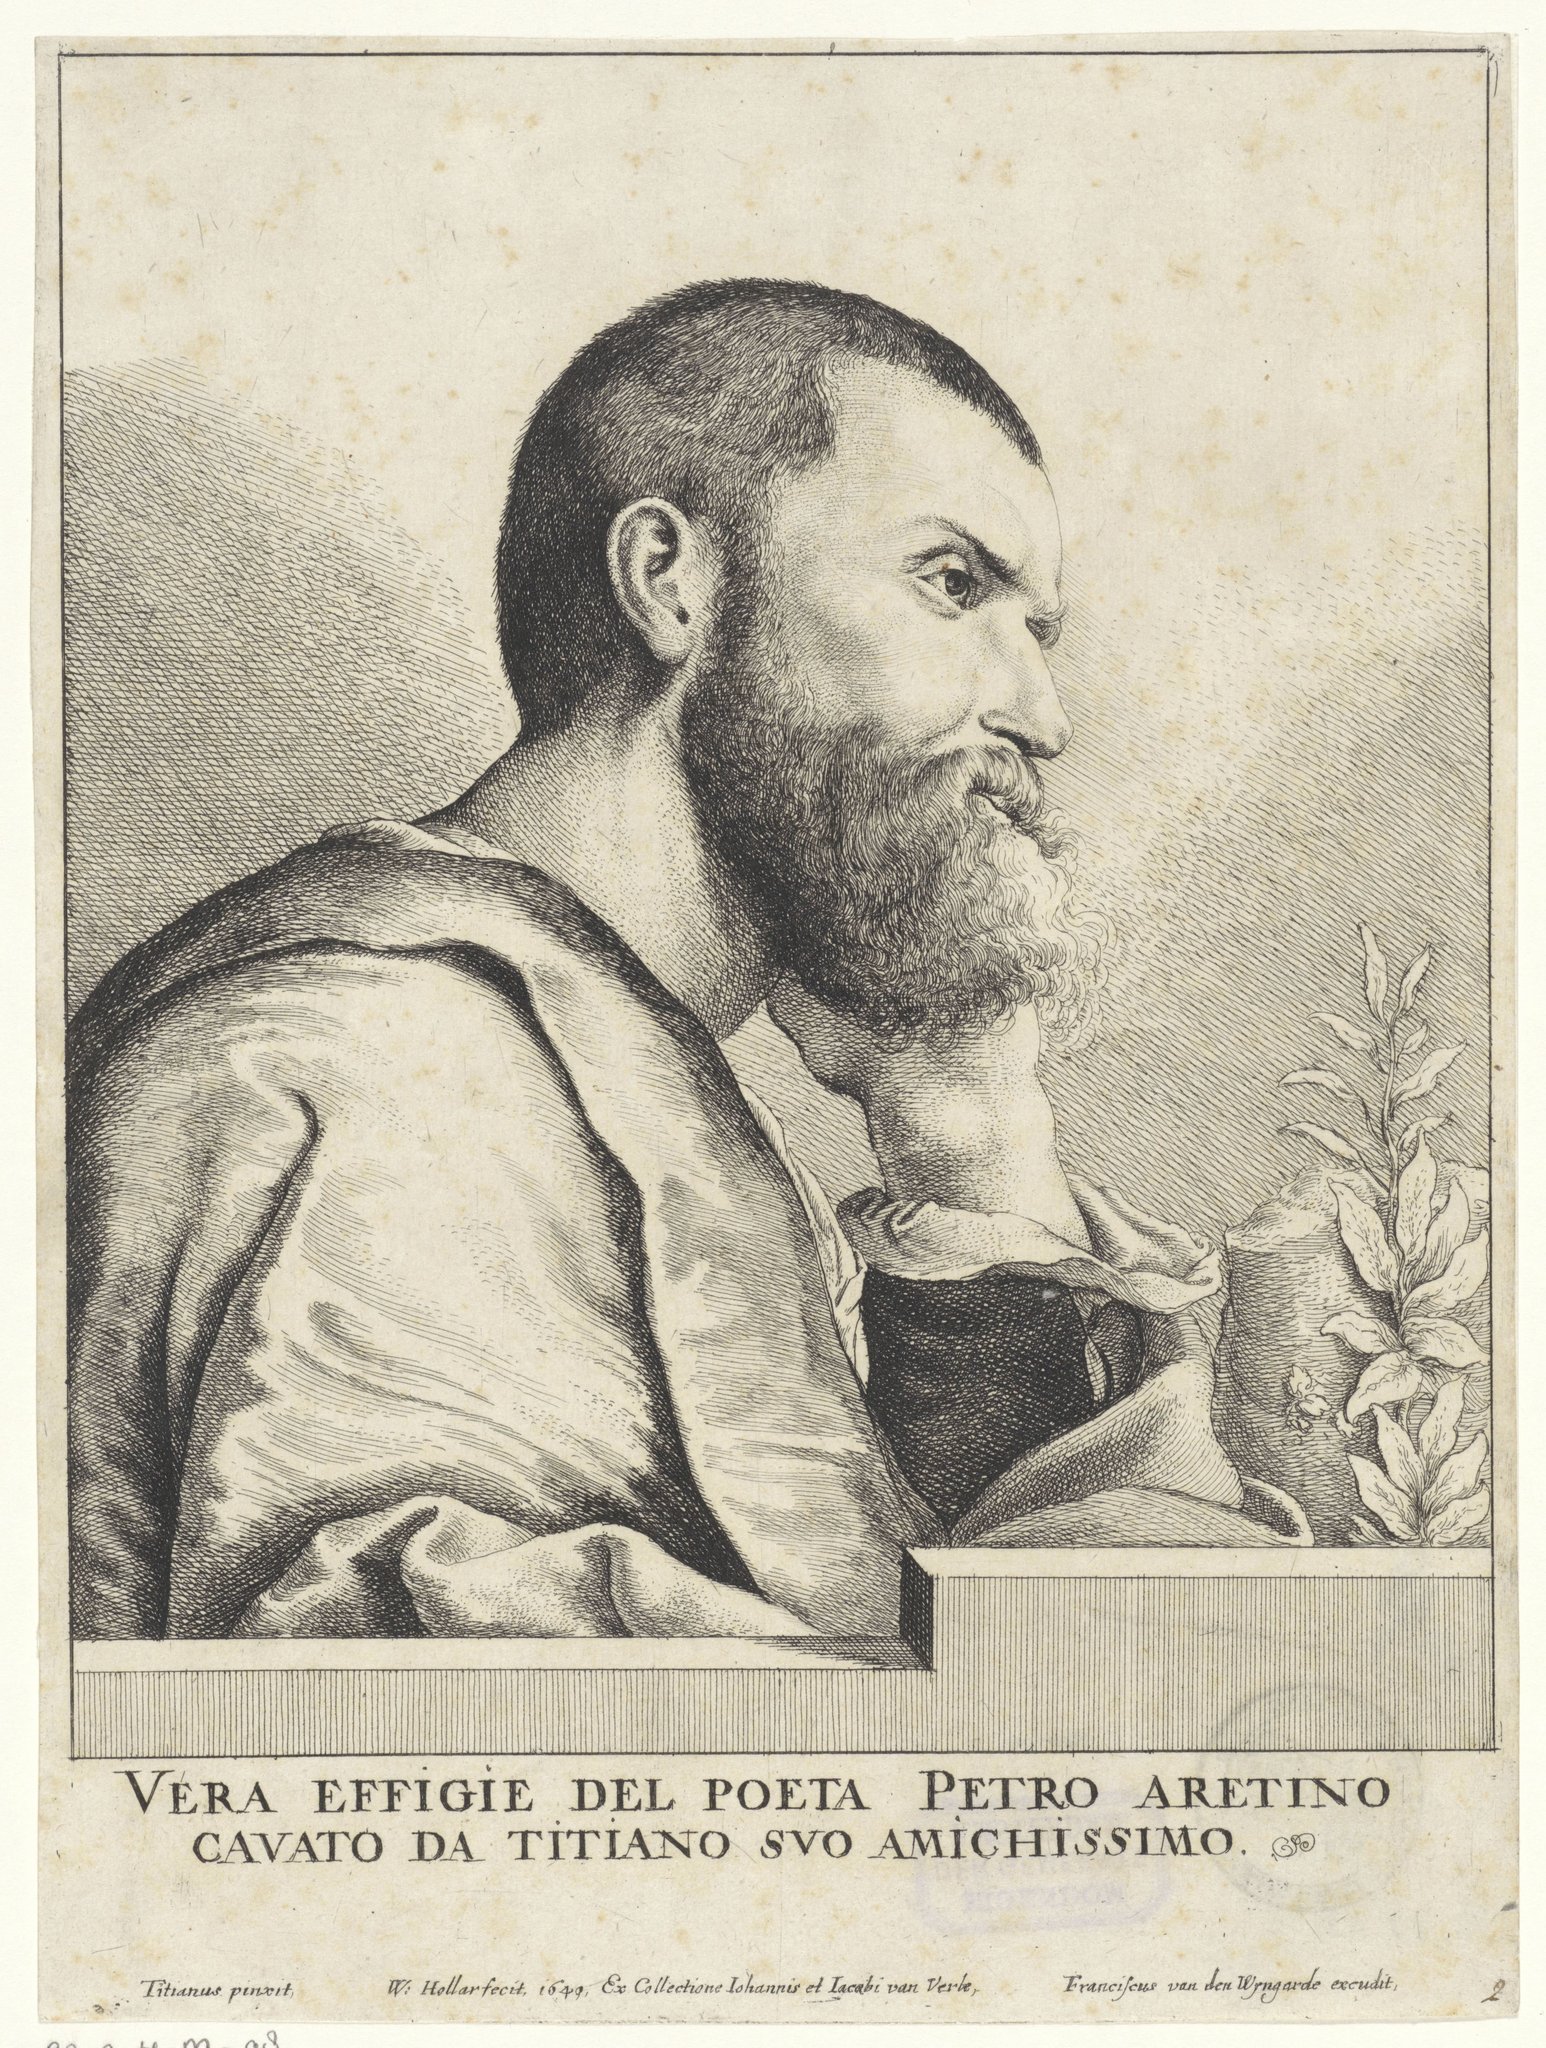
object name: print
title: Italiaanse portretten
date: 1649-1651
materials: paper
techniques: etching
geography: antwerp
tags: venice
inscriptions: number: ‘2’, collector's mark: Lugt 11, collector's mark: Lugt 10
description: De prent maakt deel uit van een tiendelige serie met Italiaanse portretten (ongenummerd).